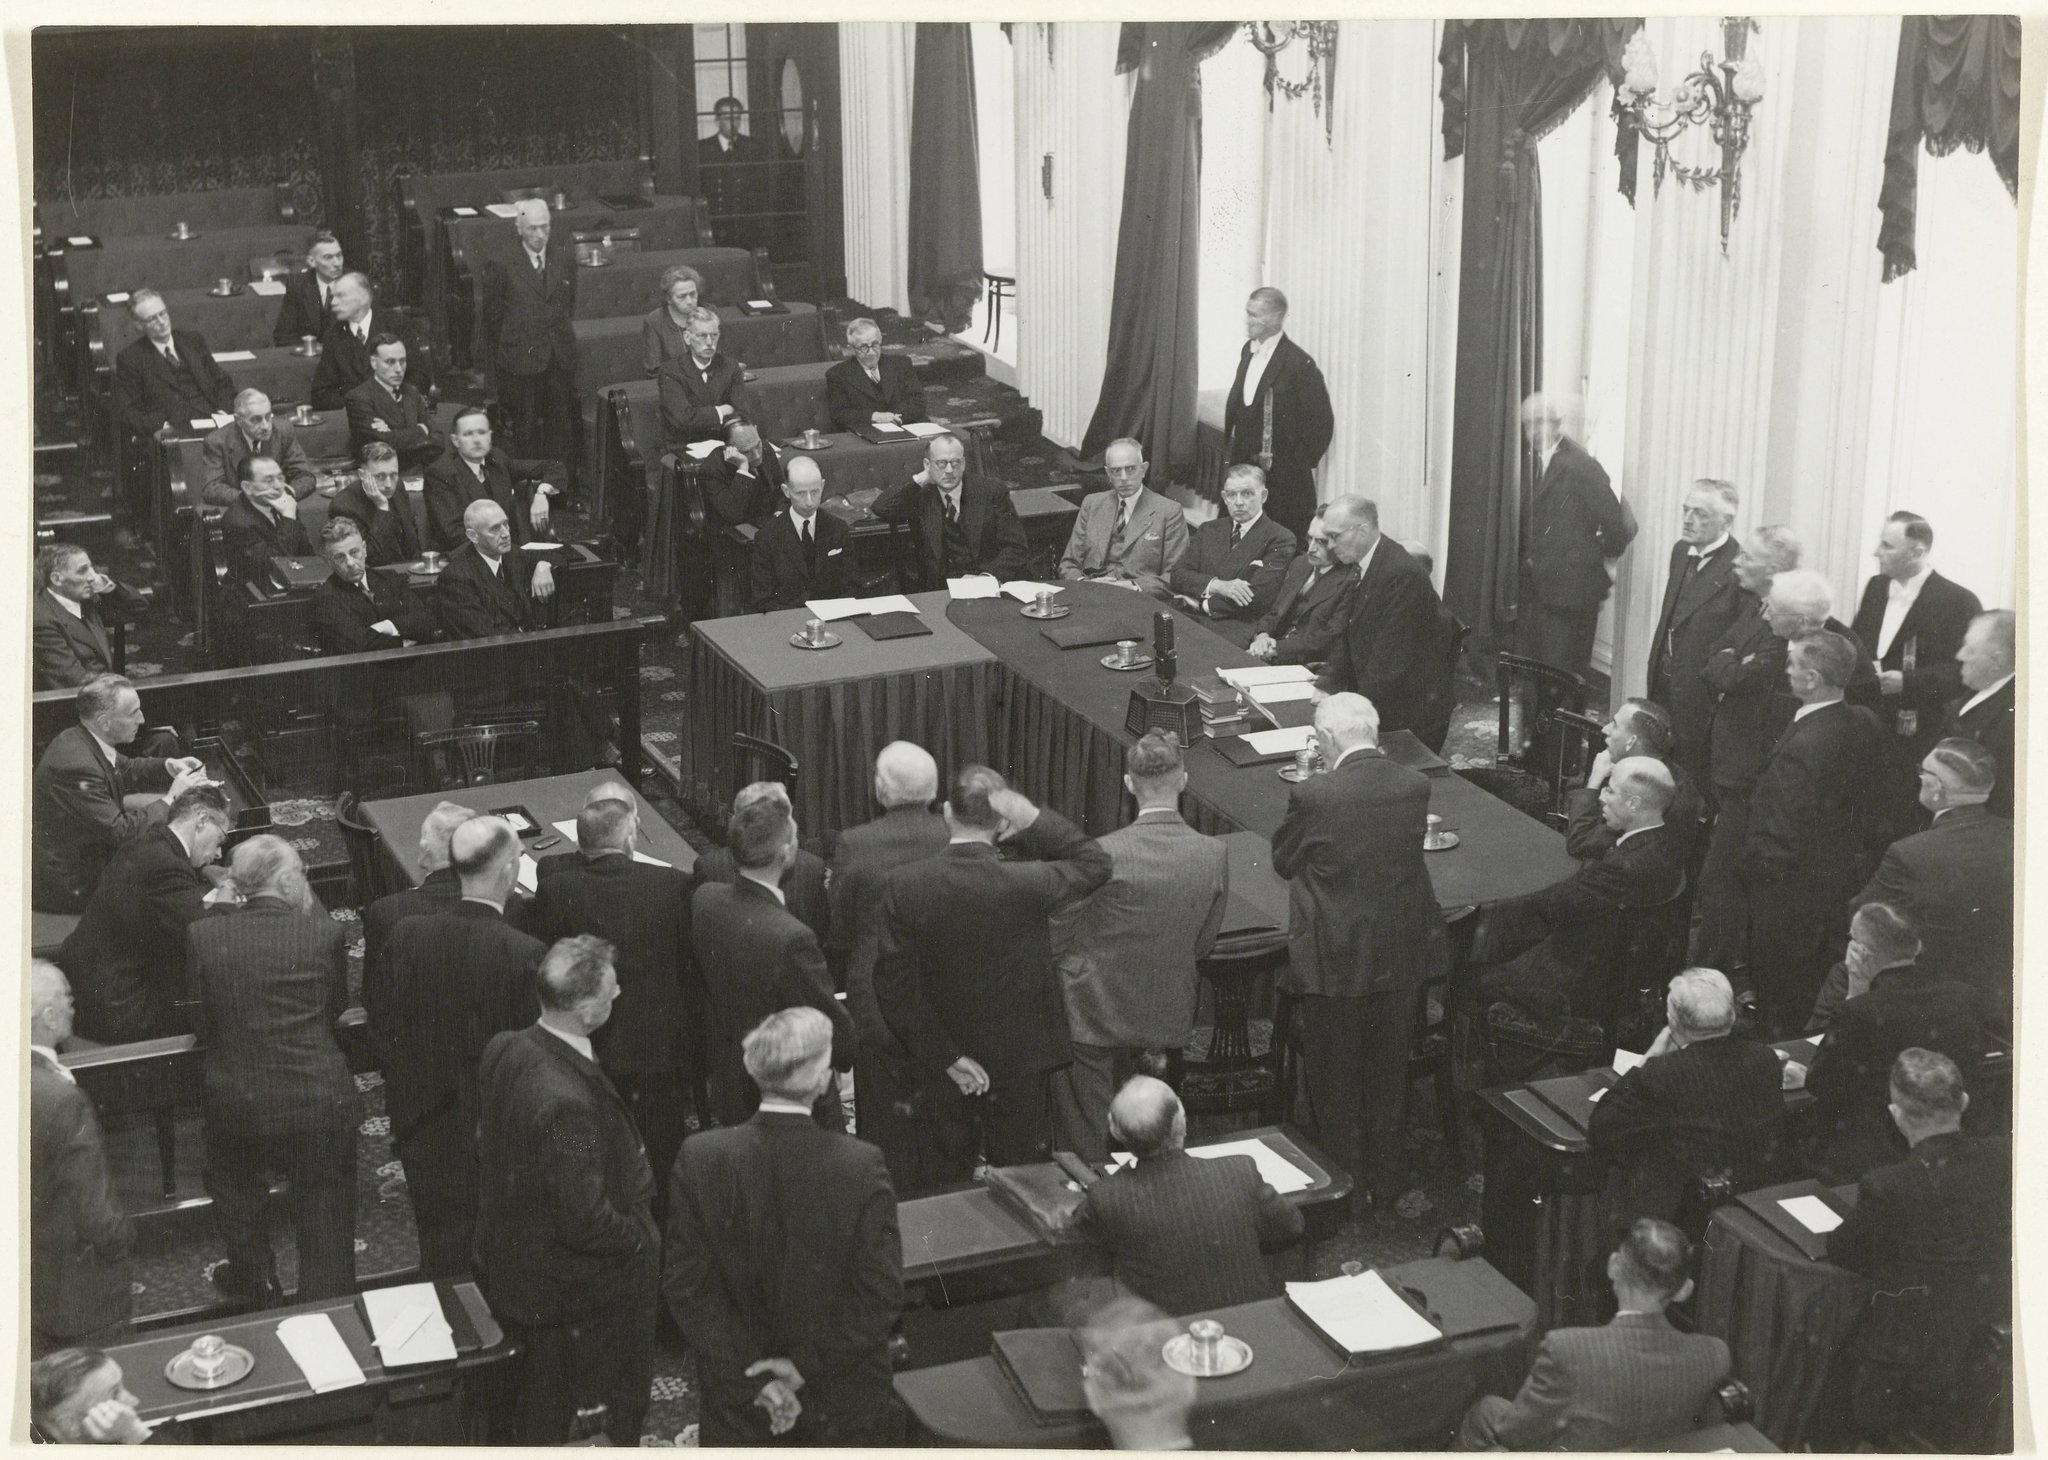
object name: documentary photograph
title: Verklaring van Minister Logemann in de Tweede Kamer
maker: meyer (fotograaf)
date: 1910-1945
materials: paper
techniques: photography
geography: the hague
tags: rotterdam, politician, amsterdam, the hague, willem drees